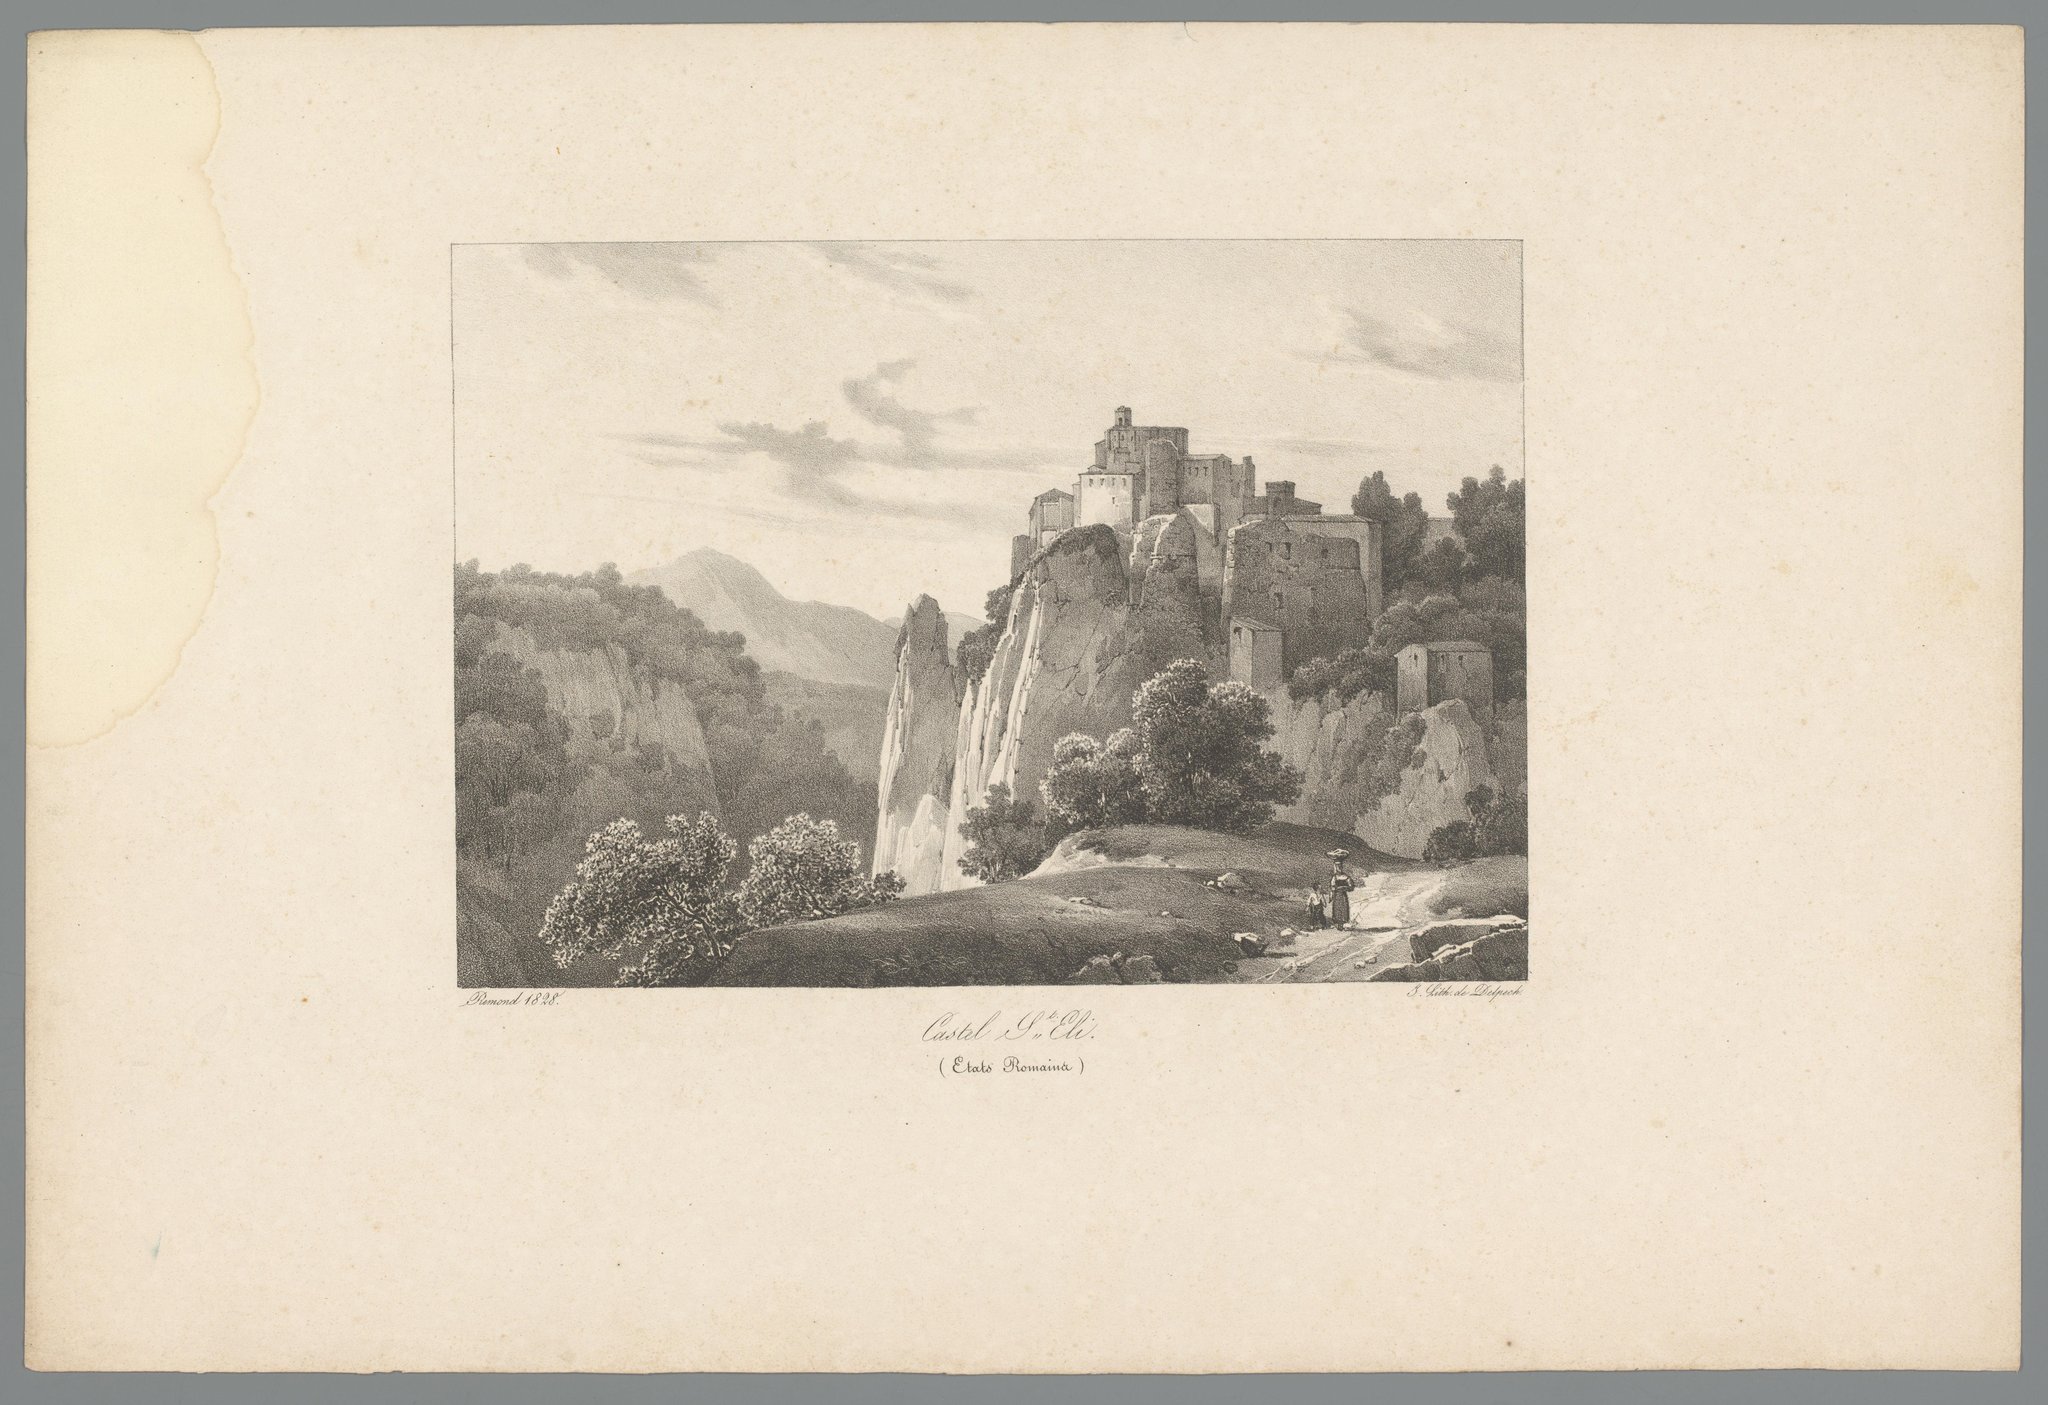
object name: print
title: Castel St. Eli. (Etats Romains)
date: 1828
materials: paper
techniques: lithograph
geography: paris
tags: rock-formations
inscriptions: collector's mark: Lugt 2228